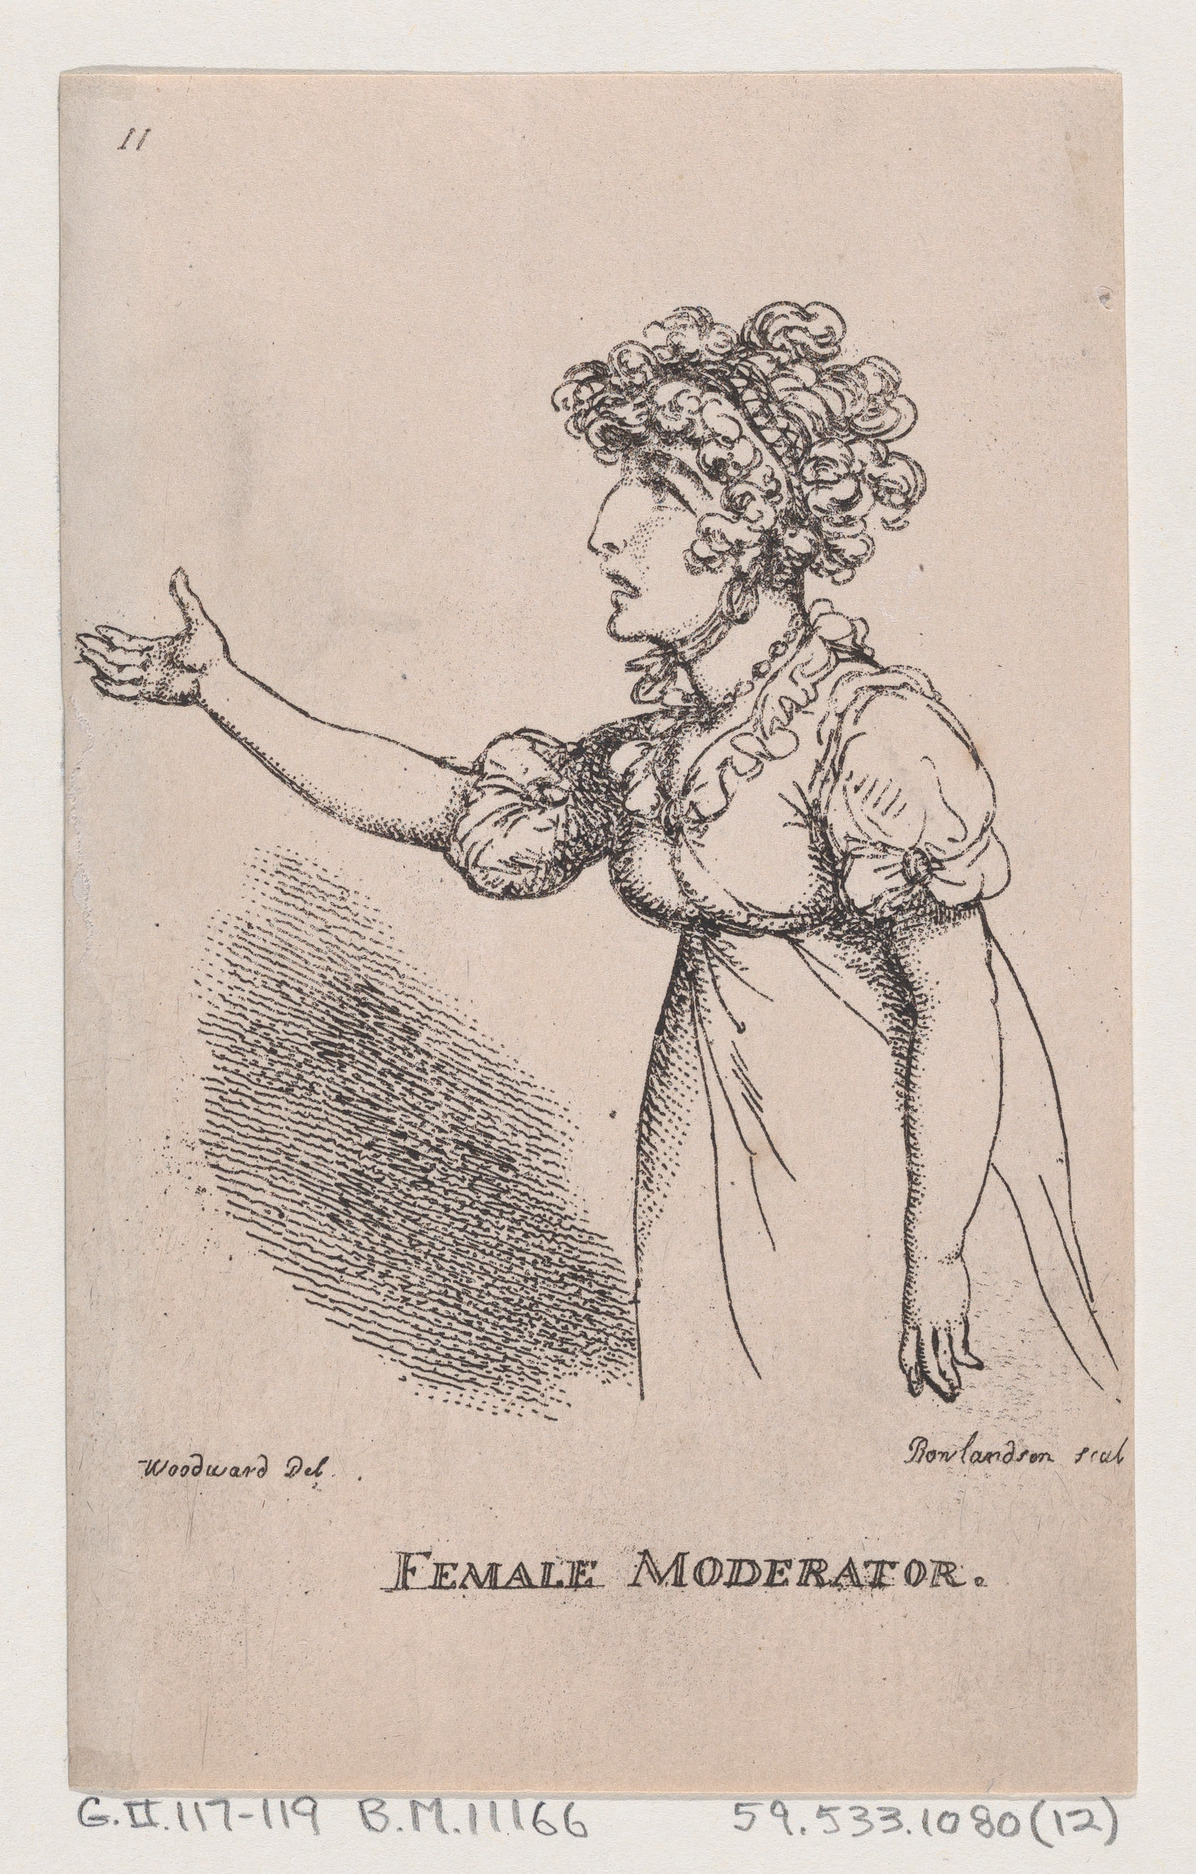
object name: print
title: Female Moderator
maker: thomas rowlandson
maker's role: artist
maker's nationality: british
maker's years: 1757-1827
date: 1808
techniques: etching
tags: profiles,women